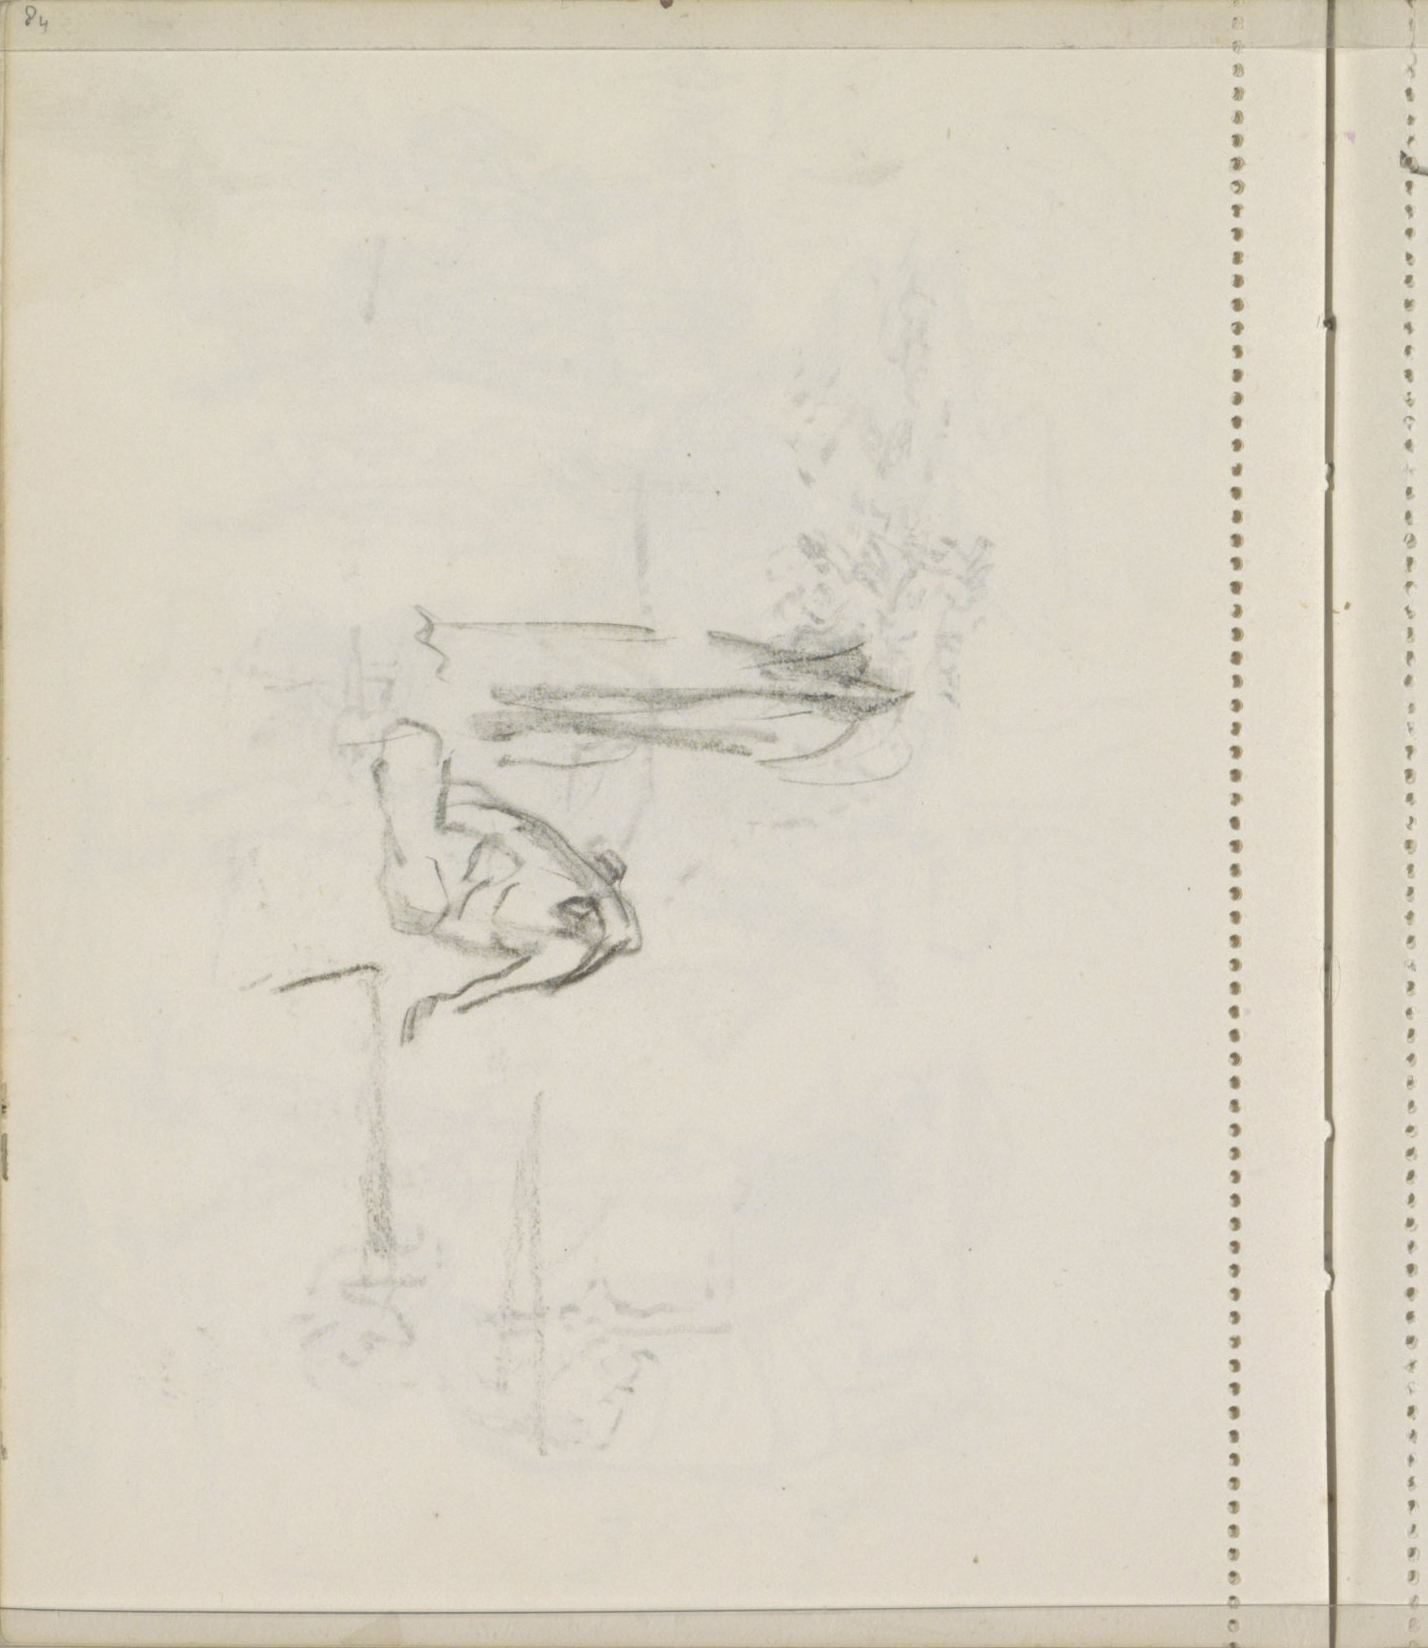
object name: sketchbook leaf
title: Staande en zittende figuur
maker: marius bauer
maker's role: draughtsman, print maker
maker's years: 1867-1932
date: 1925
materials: chalk, paper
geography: indonesia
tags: standing figure, sitting figure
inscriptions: kleurnotitie, handgeschreven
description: Pagina 84 uit een schetsboek met 67 bladen.